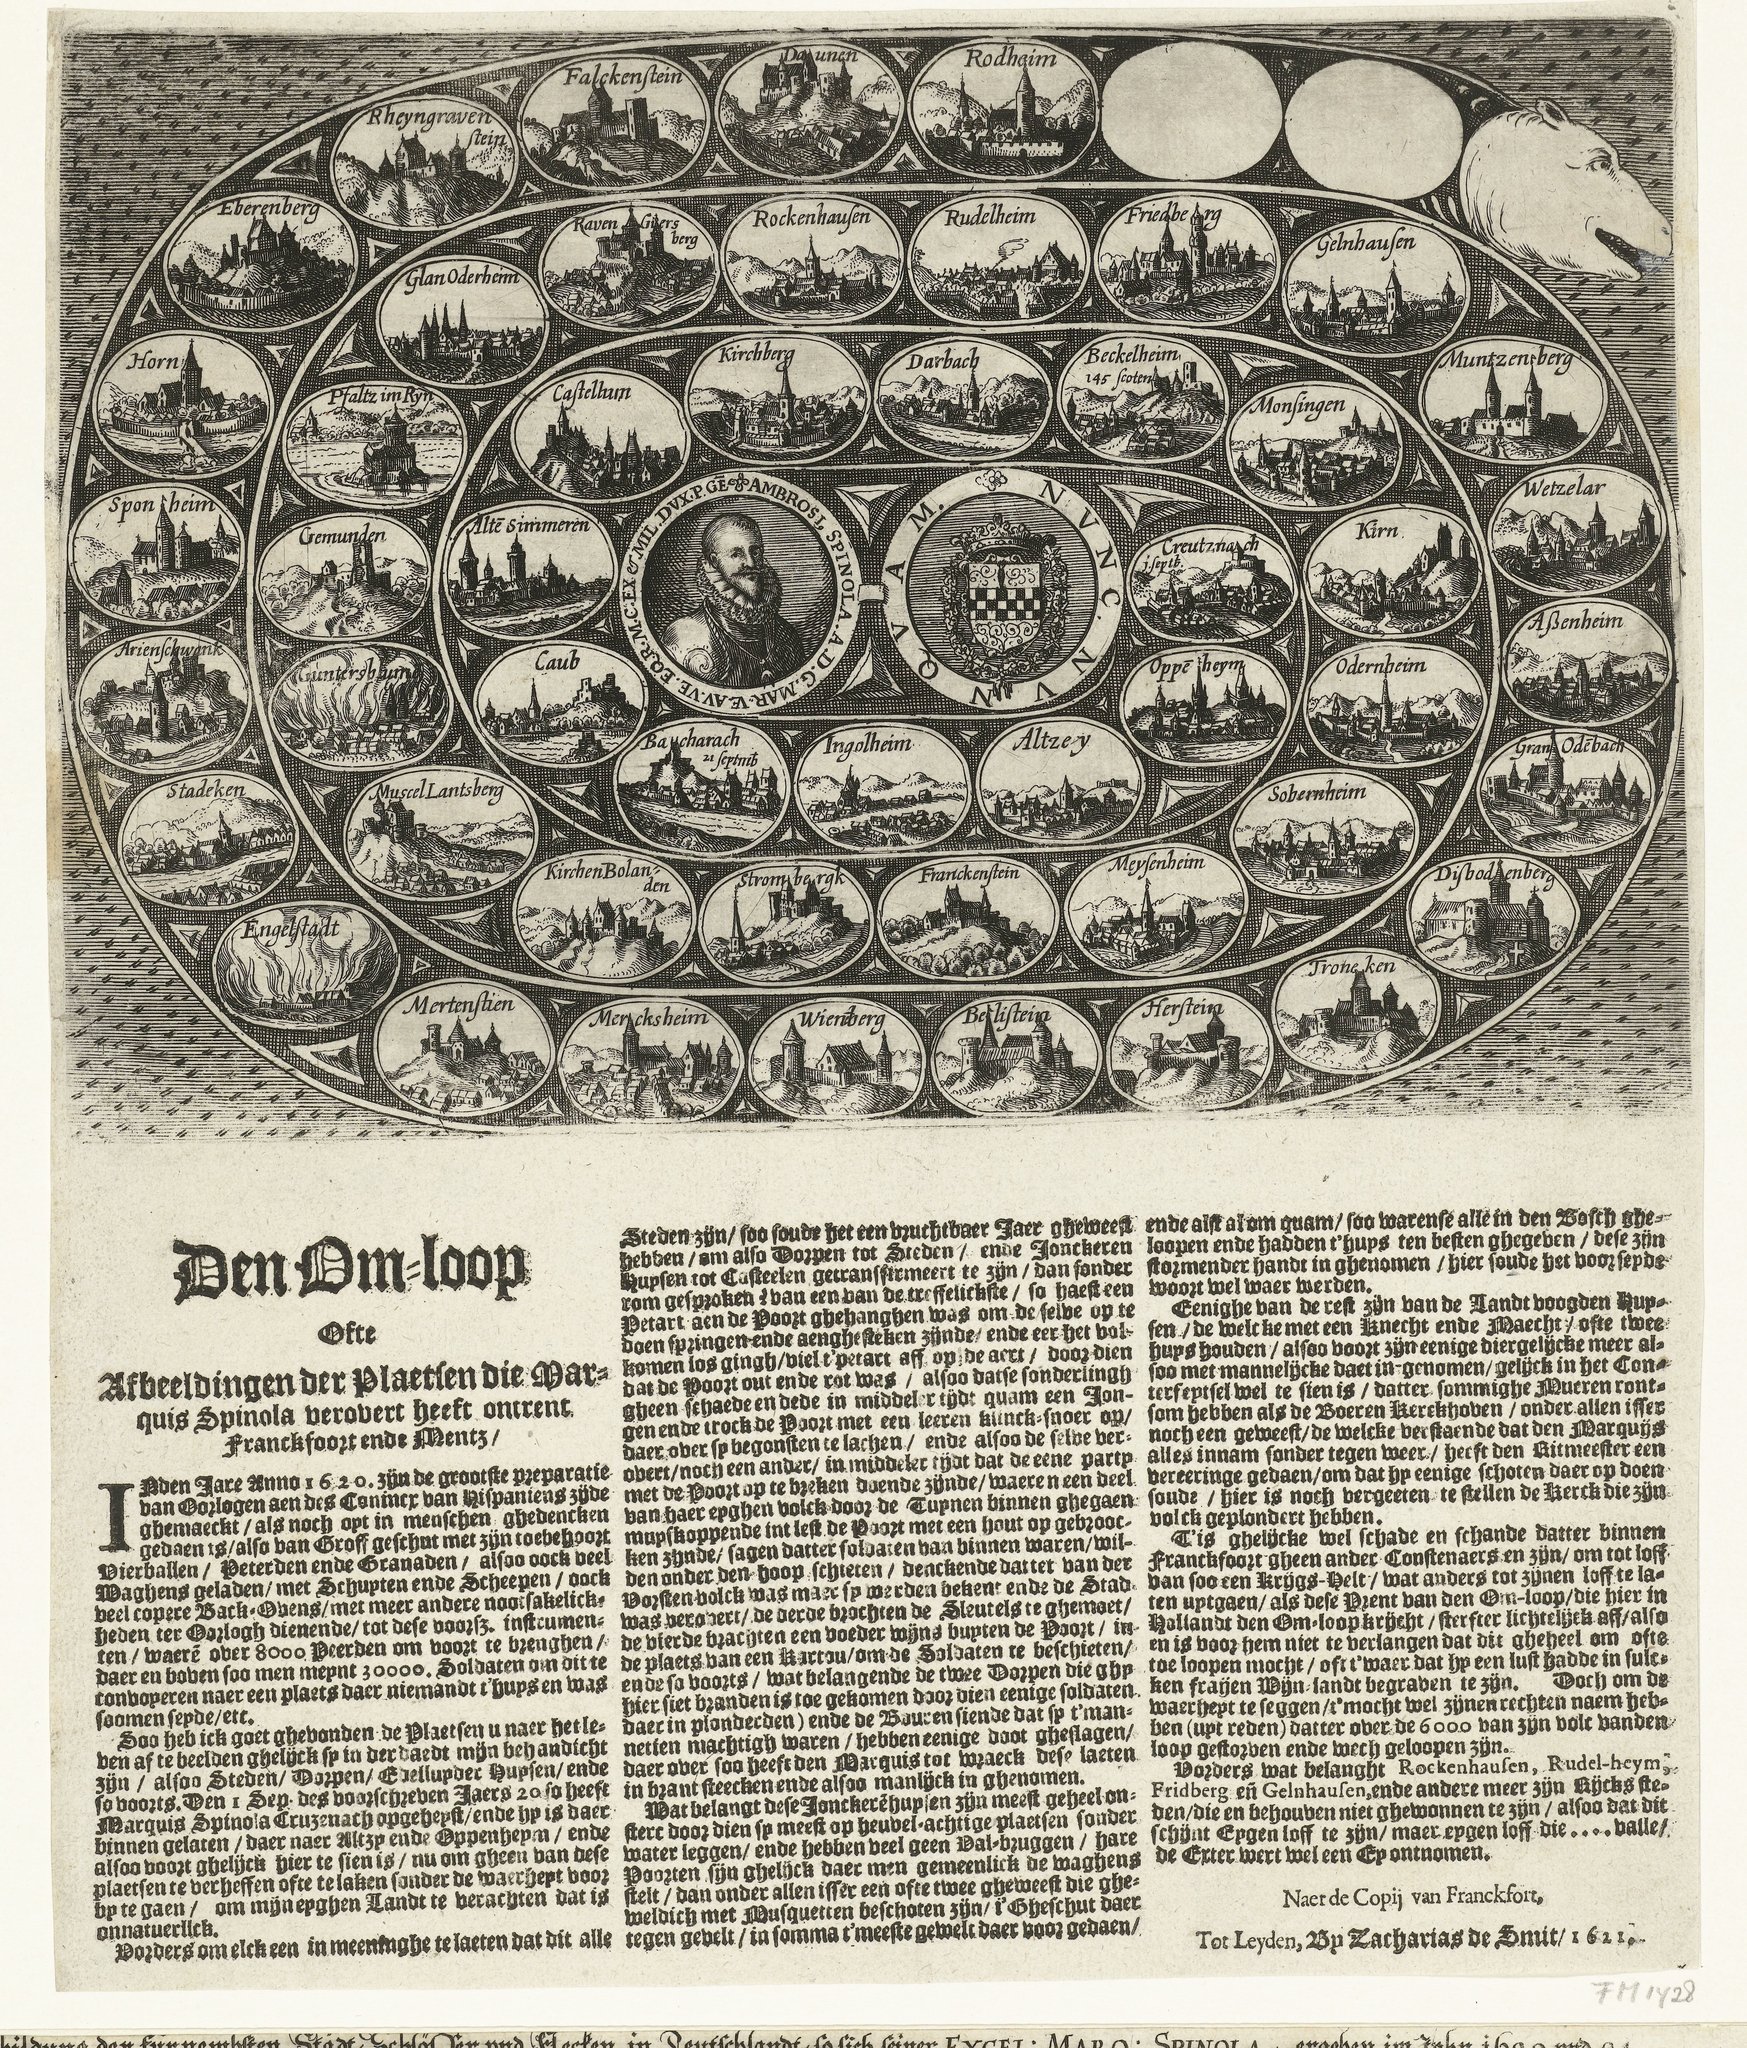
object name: print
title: Den Om-loop Ofte Afbeeldingen der Plaetsen die Marquis Spinola verovert heeft ontrent Franckfoort ende Mentz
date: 1621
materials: paper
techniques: engraving, etching, letterpress printing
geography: low countries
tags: goose-game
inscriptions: date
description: Een opgerolde slang opgebouwd uit medaillons met alle door Spinola veroverde Duitse steden in de jaren 1620-1621. In het midden een portretje en het wapen van de markies. Onder de prent gedrukt een tekst in 3 kolommen in het Nederlands.